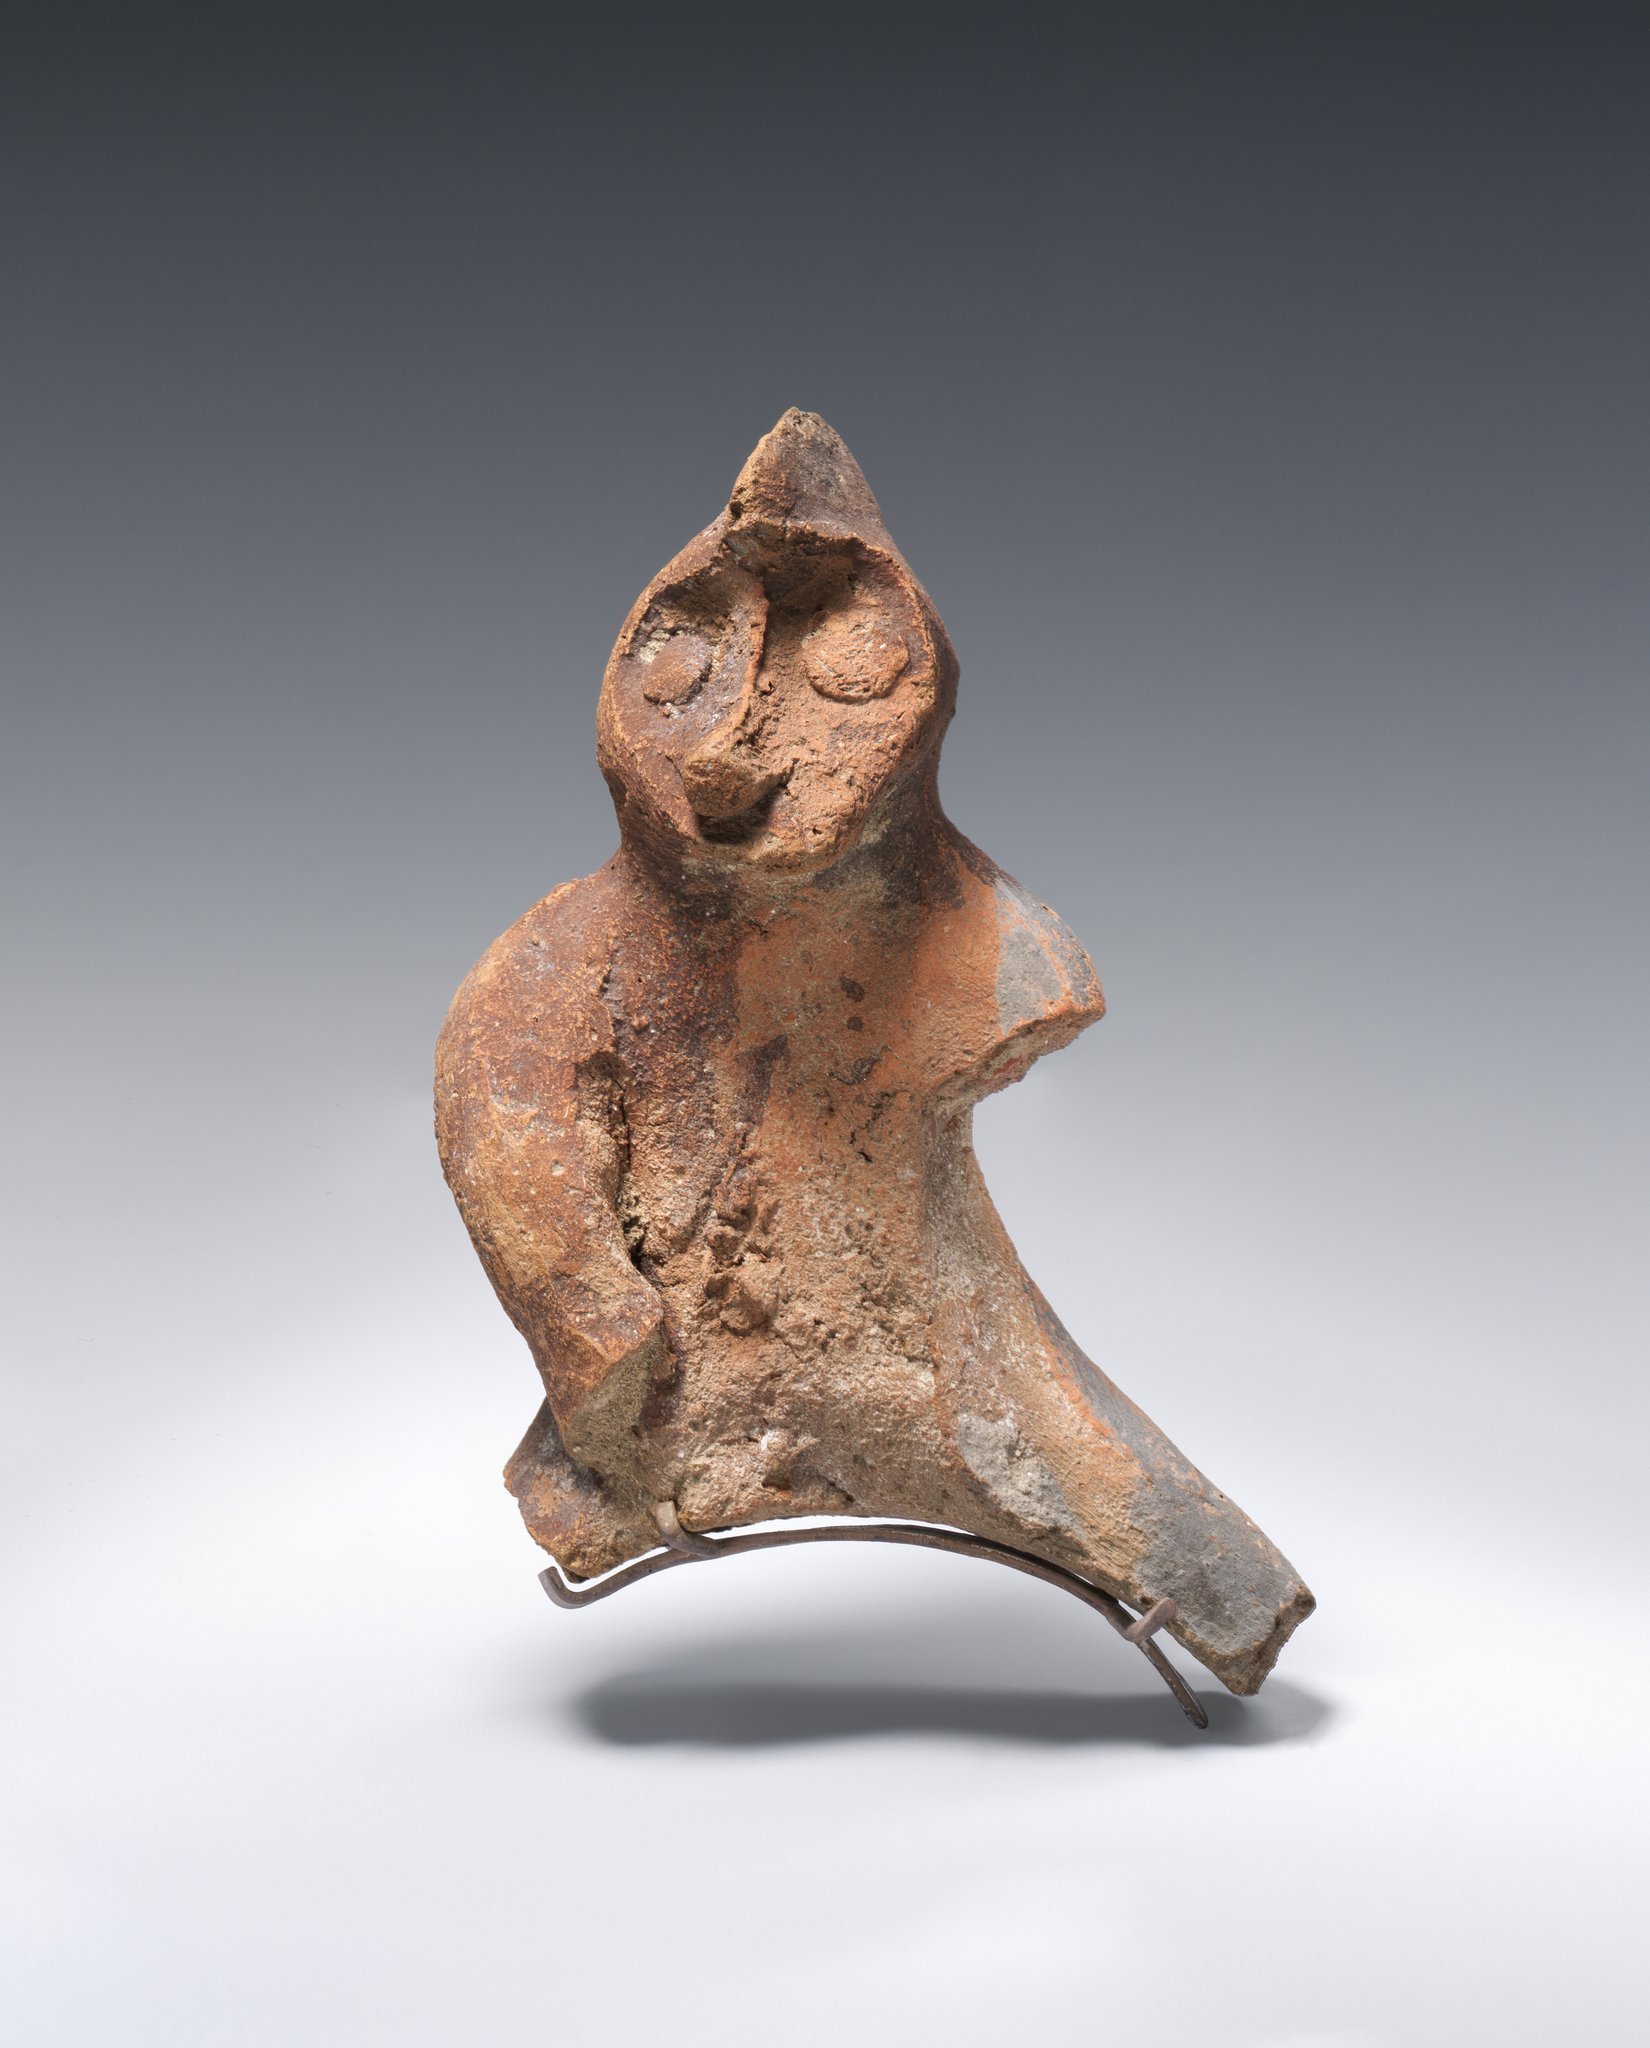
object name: figurine, human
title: Figurine of a Man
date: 306-30 BCE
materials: paint, pottery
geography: egypt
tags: men